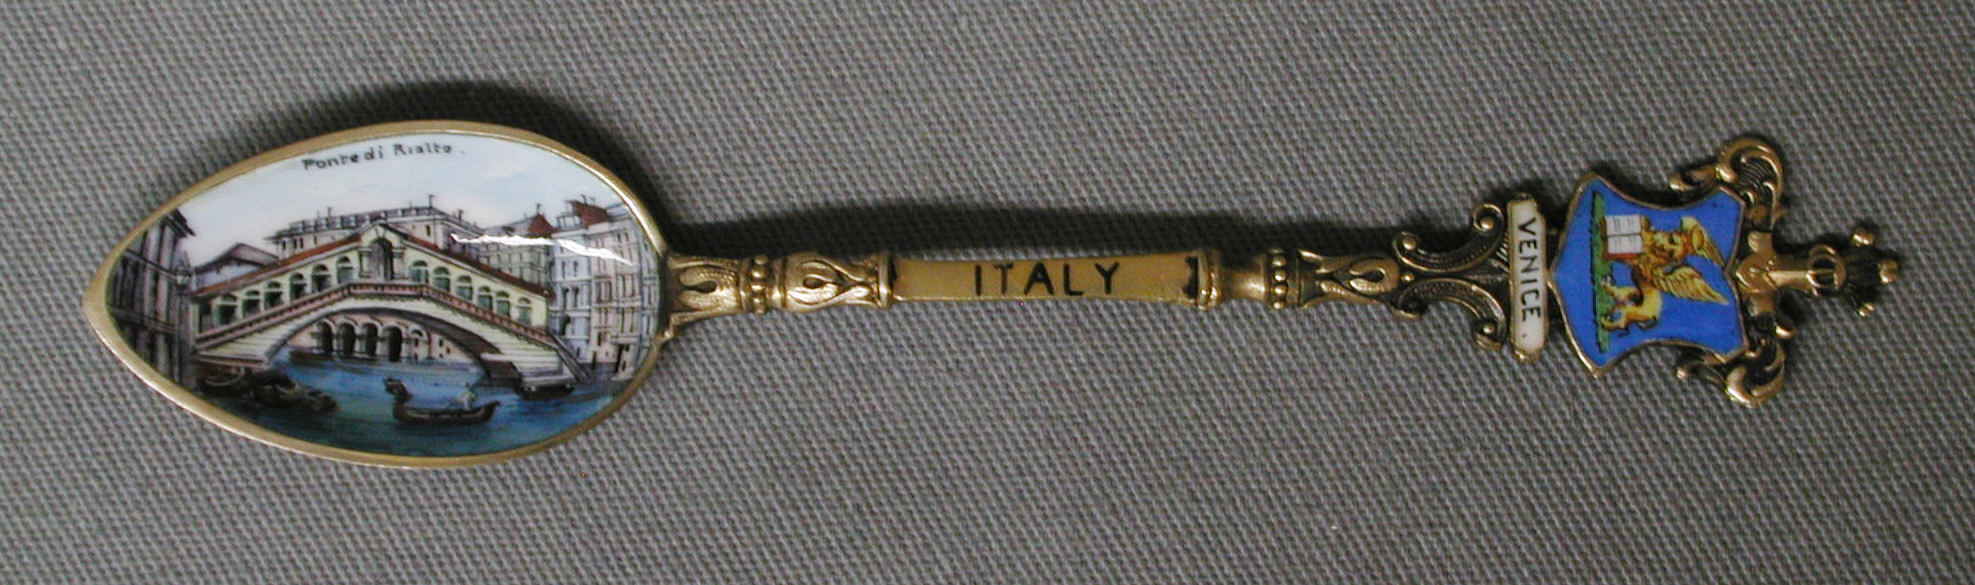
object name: souvenir spoon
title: Souvenir spoon with view of the Rialto Bridge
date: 1867-1900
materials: enamel, silver gilt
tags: bridges,coat of arms